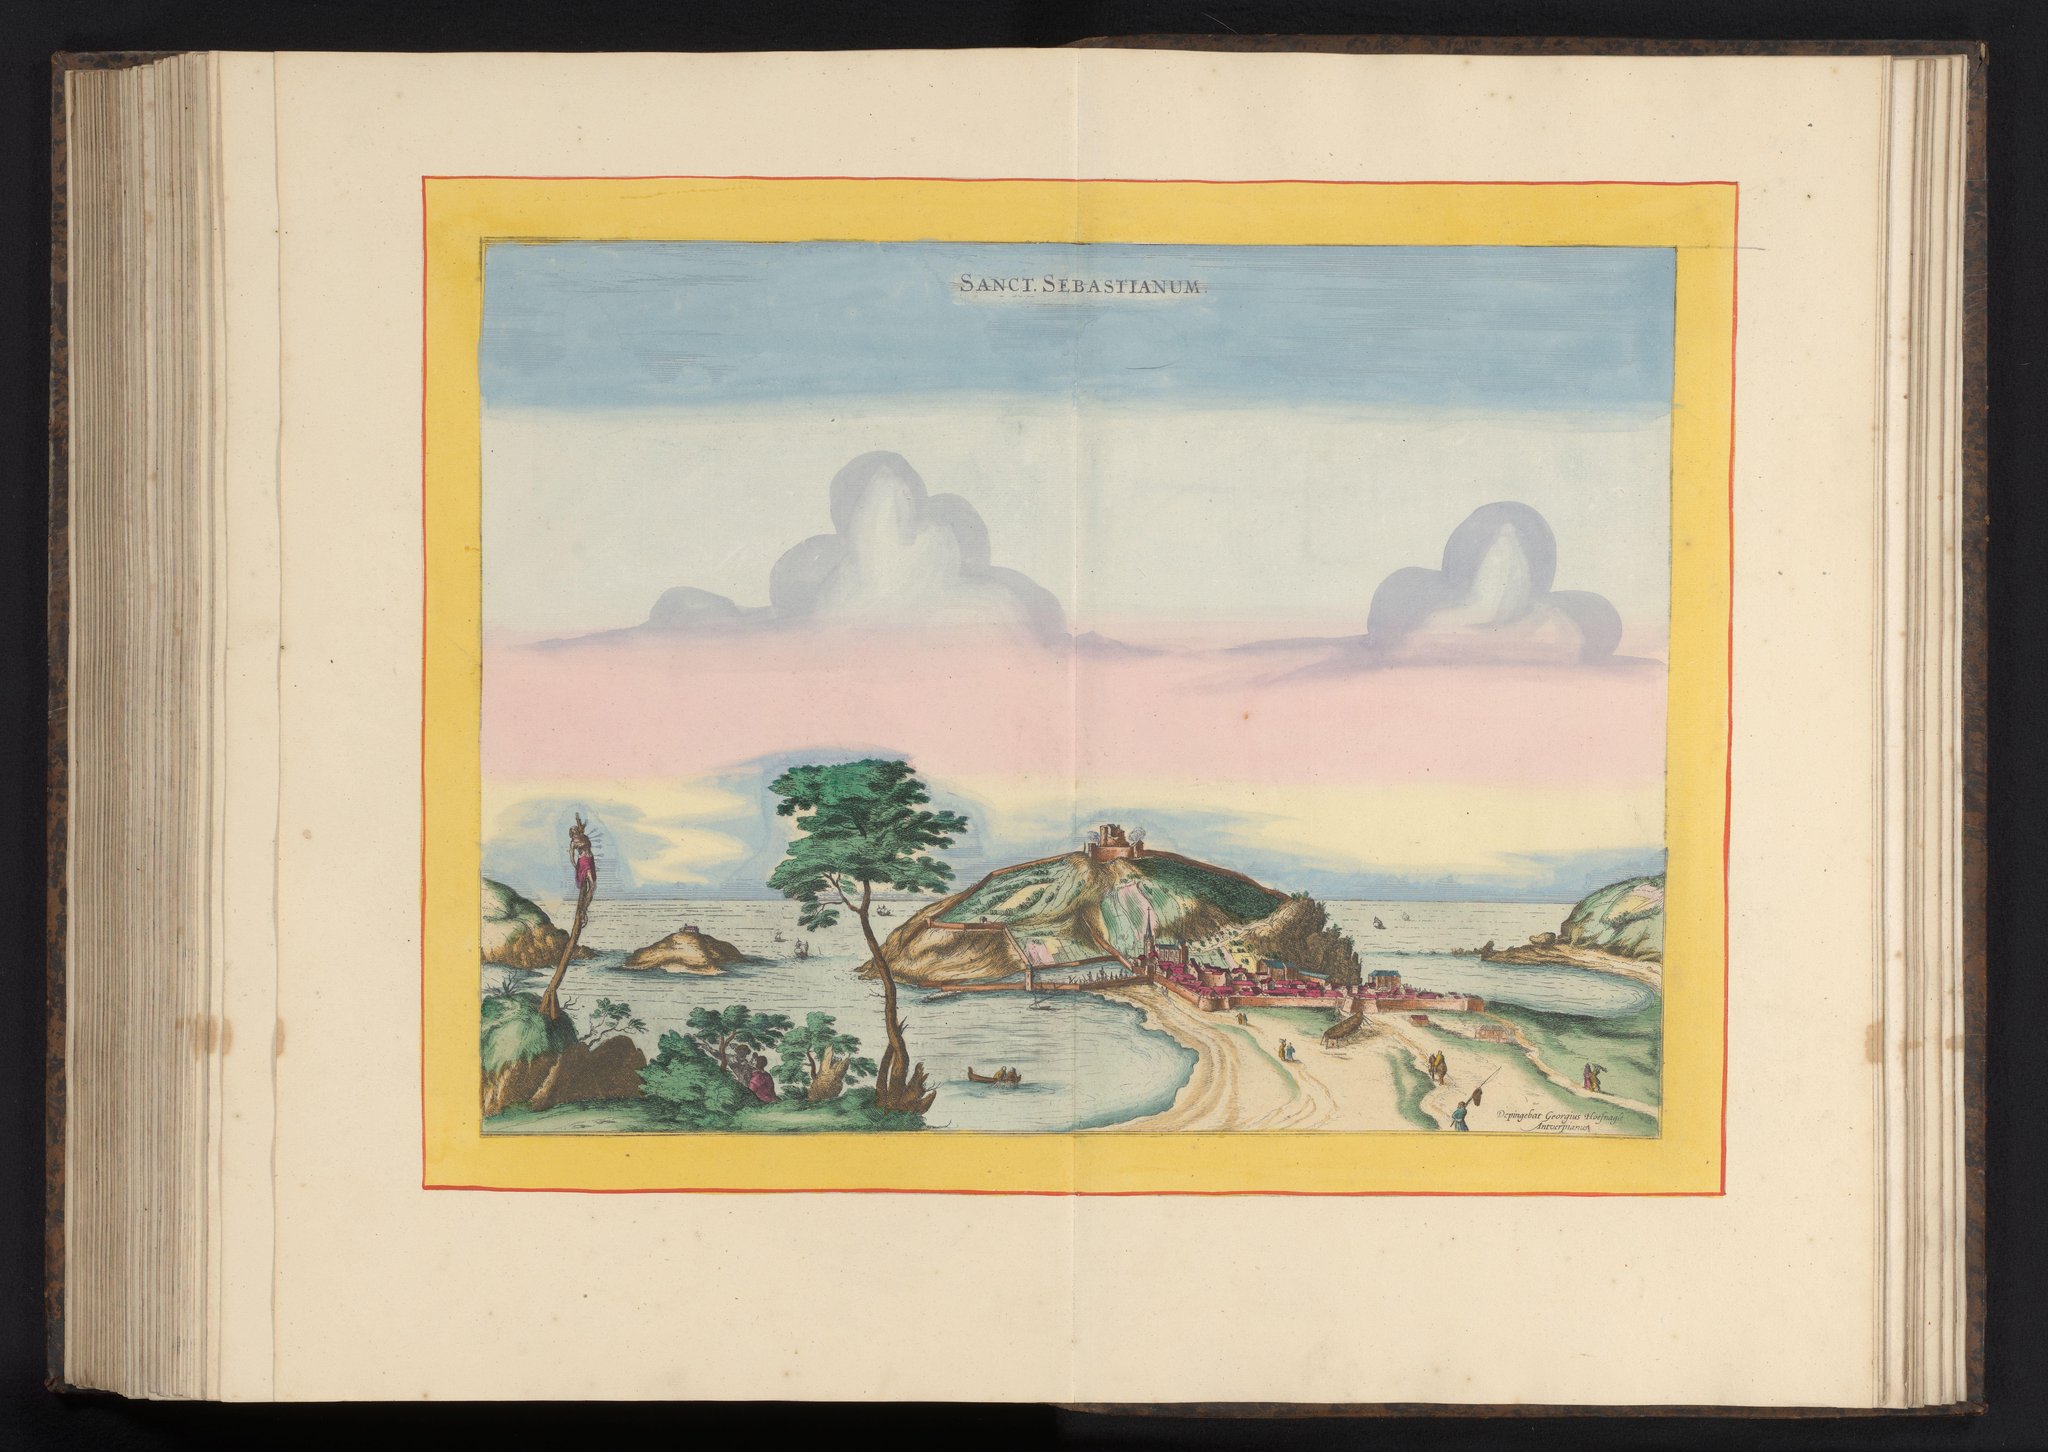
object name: album leaf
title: Gezicht op San Sebastián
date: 1572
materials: paper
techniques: engraving, etching, hand coloring, letterpress printing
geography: the hague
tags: city-view in general; 'veduta', the martyr sebastian; possible attributes: arrow(s), bow, tree-trunk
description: Prent origineel vervaardigd als boekillustratie voor: Georg Braun en Frans Hogenberg. Civitates Orbis Terrarum, 6 delen. Keulen: 1572-1617. De prent werd voor het eerst gepubliceerd in deel 1: Civitatis orbis terrarum (liber primus), 1572. De prent is langs de bovenrand van de heuvels afgescheurd. Het bovenste gedeelte met de lucht is hoger opgeplakt, zodat de lucht hoger is geworden en het formaat van de voorstelling past bij de andere groot formaatvoorstellingen in het album.